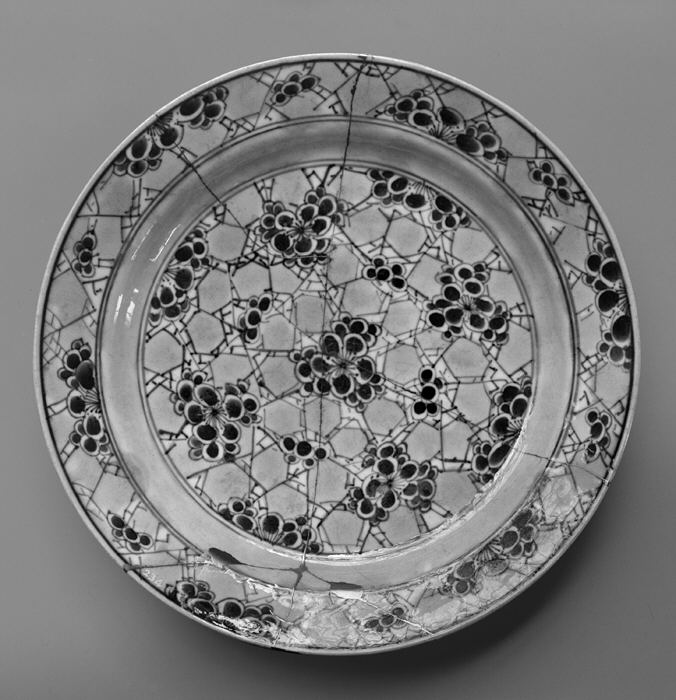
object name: dish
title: Dish with plum blossoms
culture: chinese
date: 1667-1733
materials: enamel, porcelain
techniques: overglaze, painting, polychrome